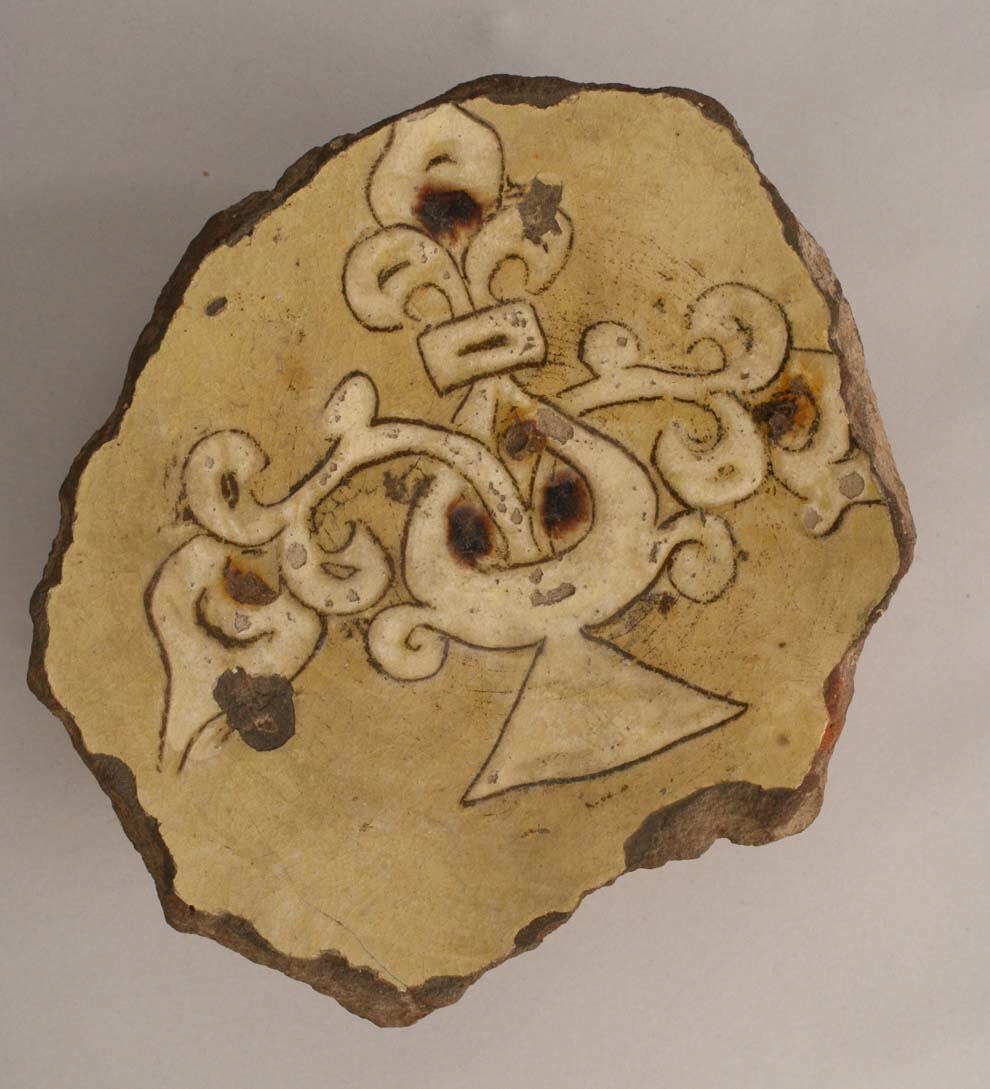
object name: fragment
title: Fragment of a Bowl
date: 1301-1400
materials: earthenware, glaze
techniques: coloring, incising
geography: egypt